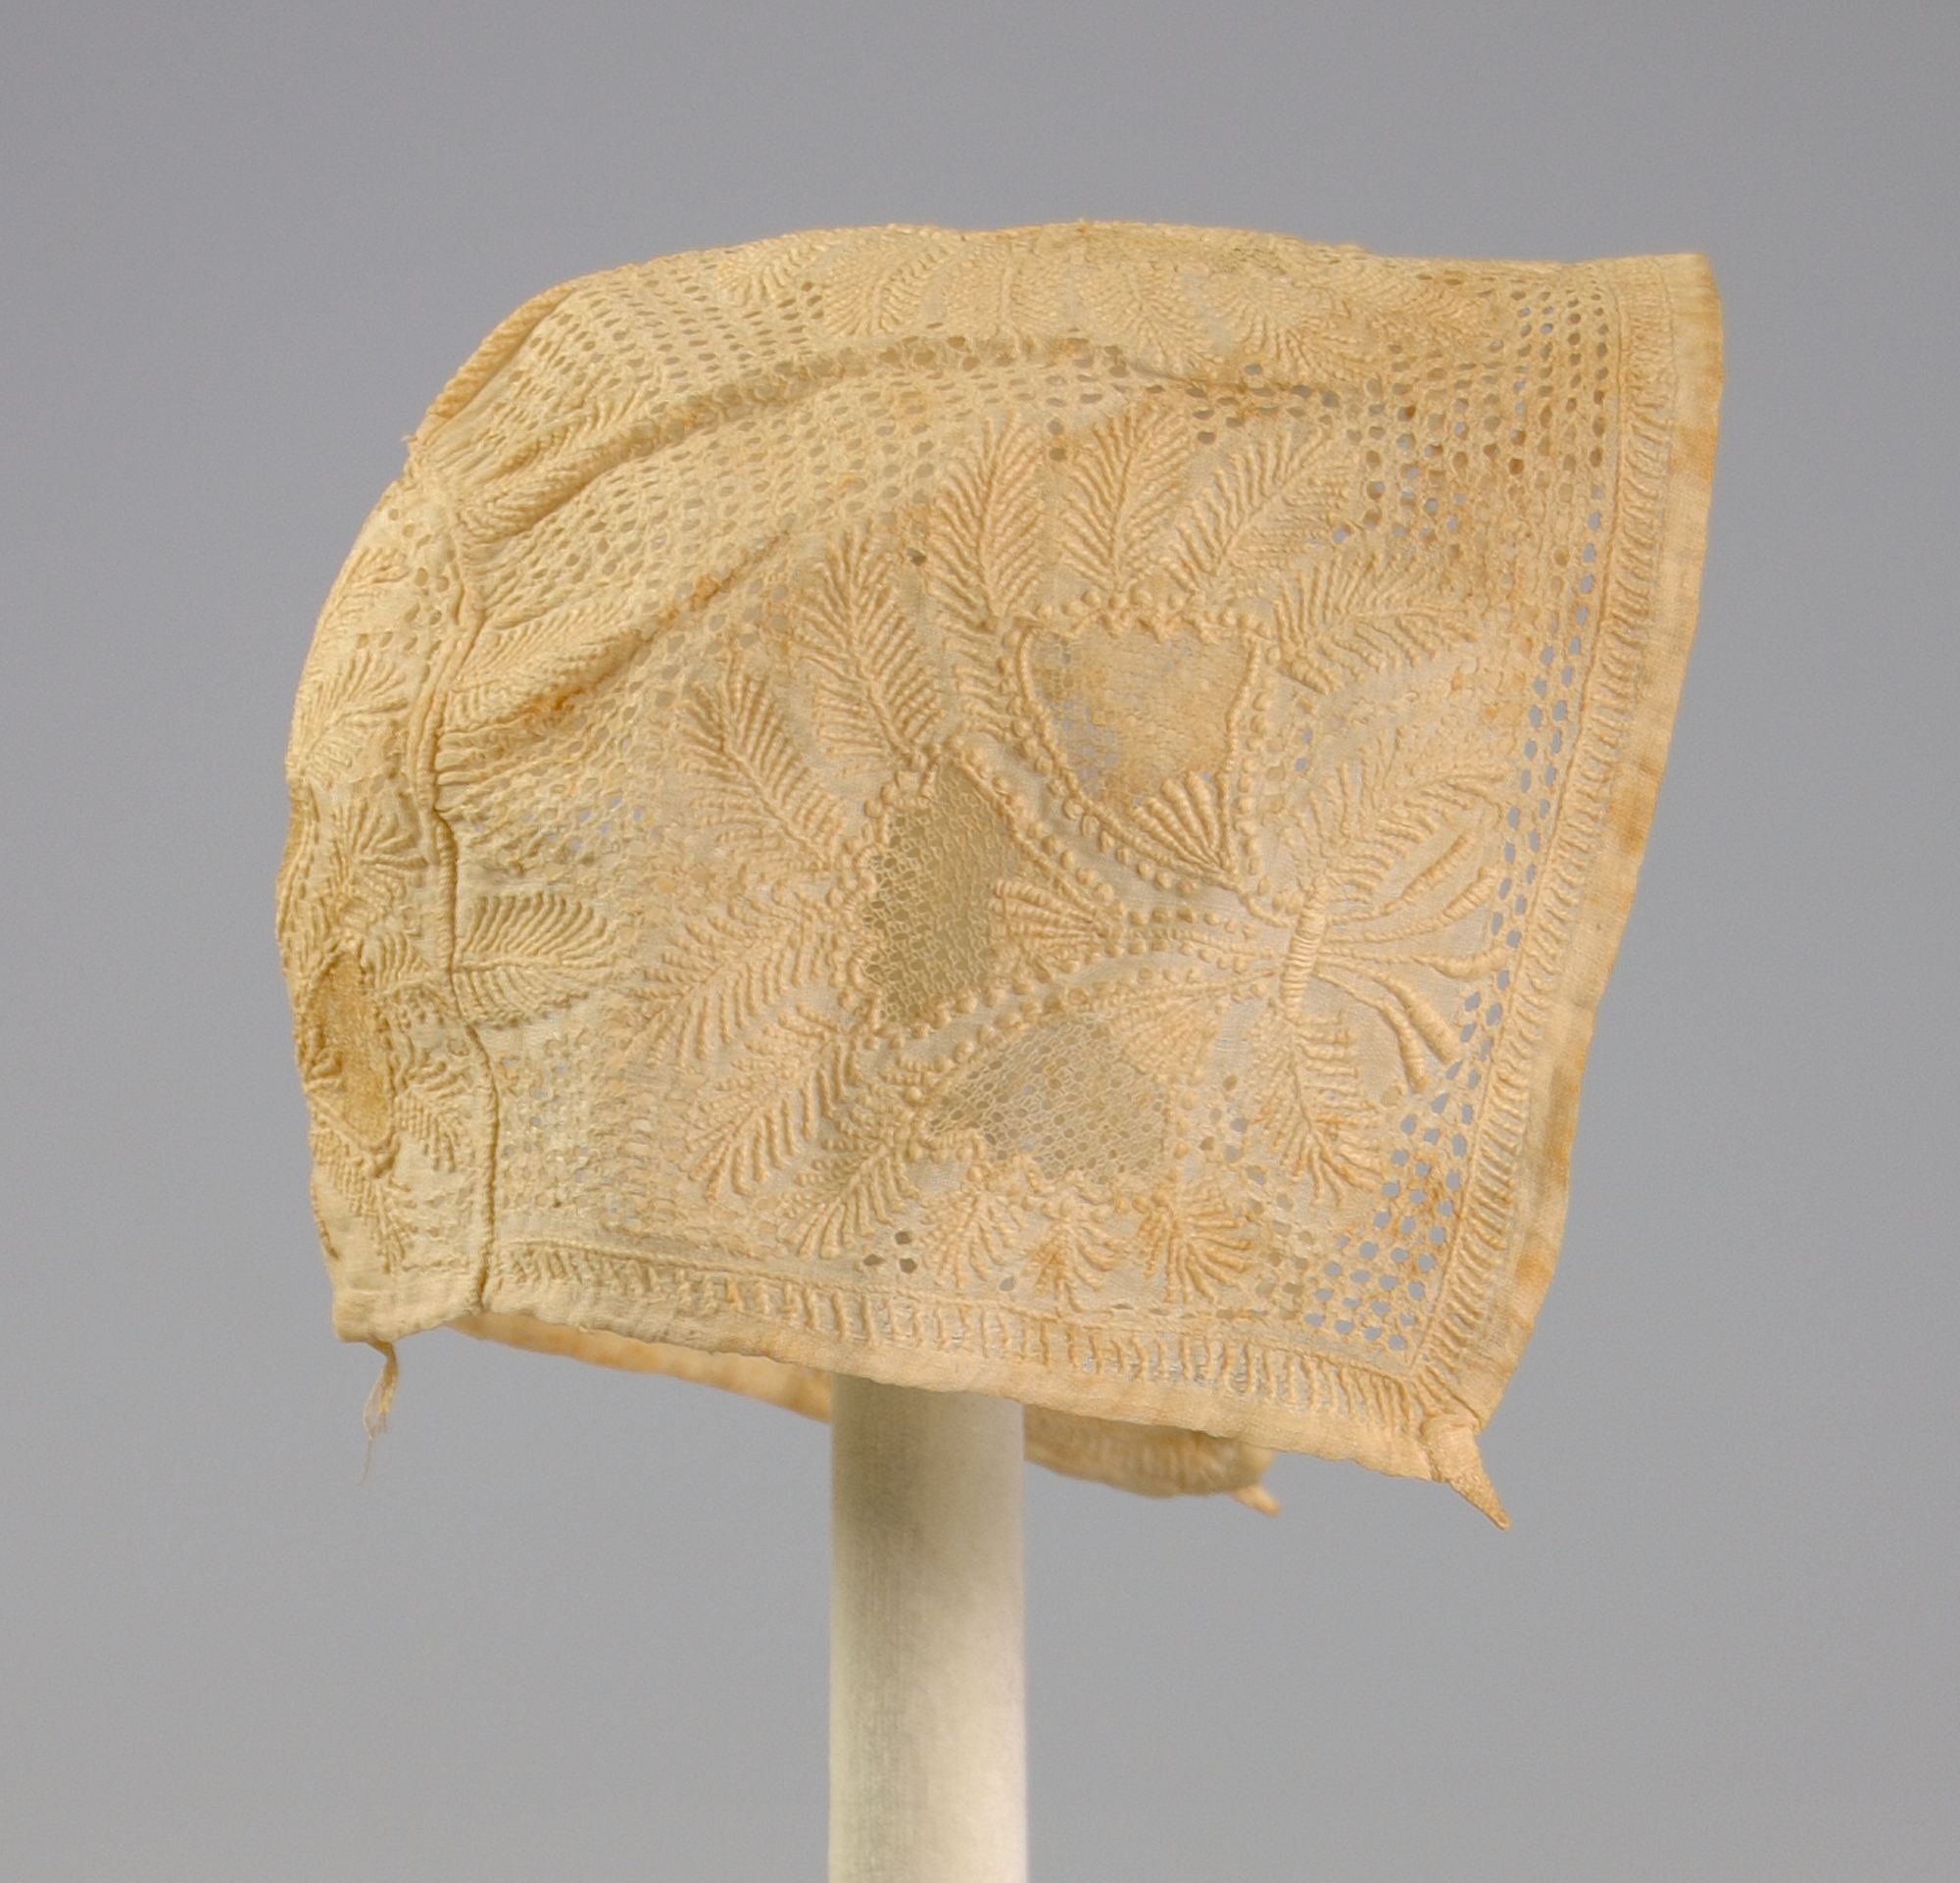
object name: cap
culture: american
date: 1830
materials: linen